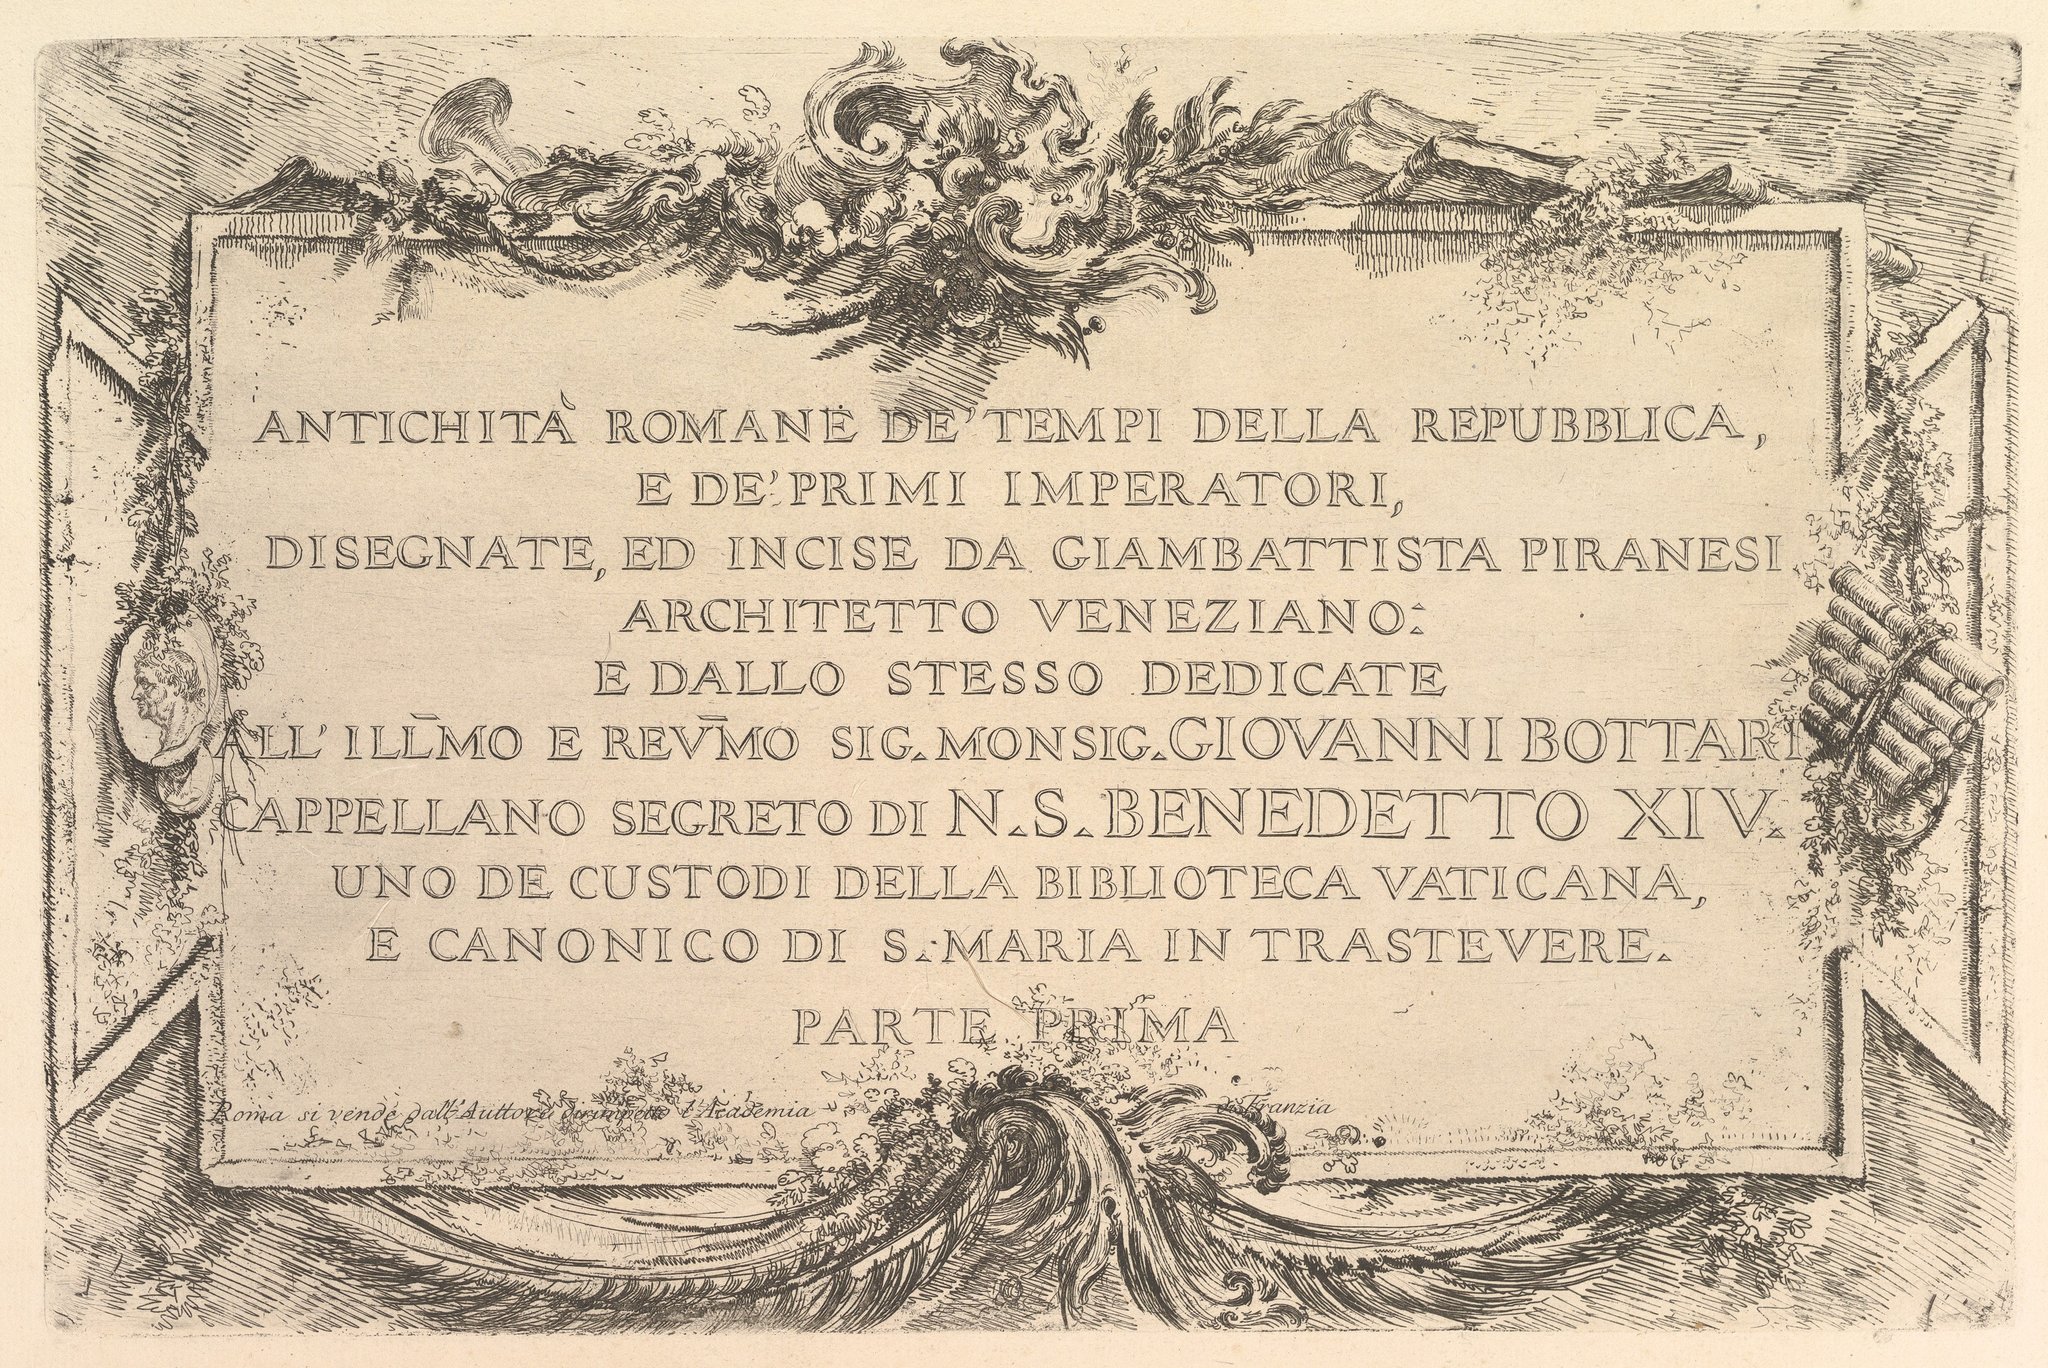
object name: print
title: Title page from "Roman Antiquity of the Time of the Republic and the First Emperors" (Antichità Romane de' Tempi della Repubblica, e de' primi Imperatori)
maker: giovanni battista piranesi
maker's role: artist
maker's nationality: italian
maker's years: 1720-1778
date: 1748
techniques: etching